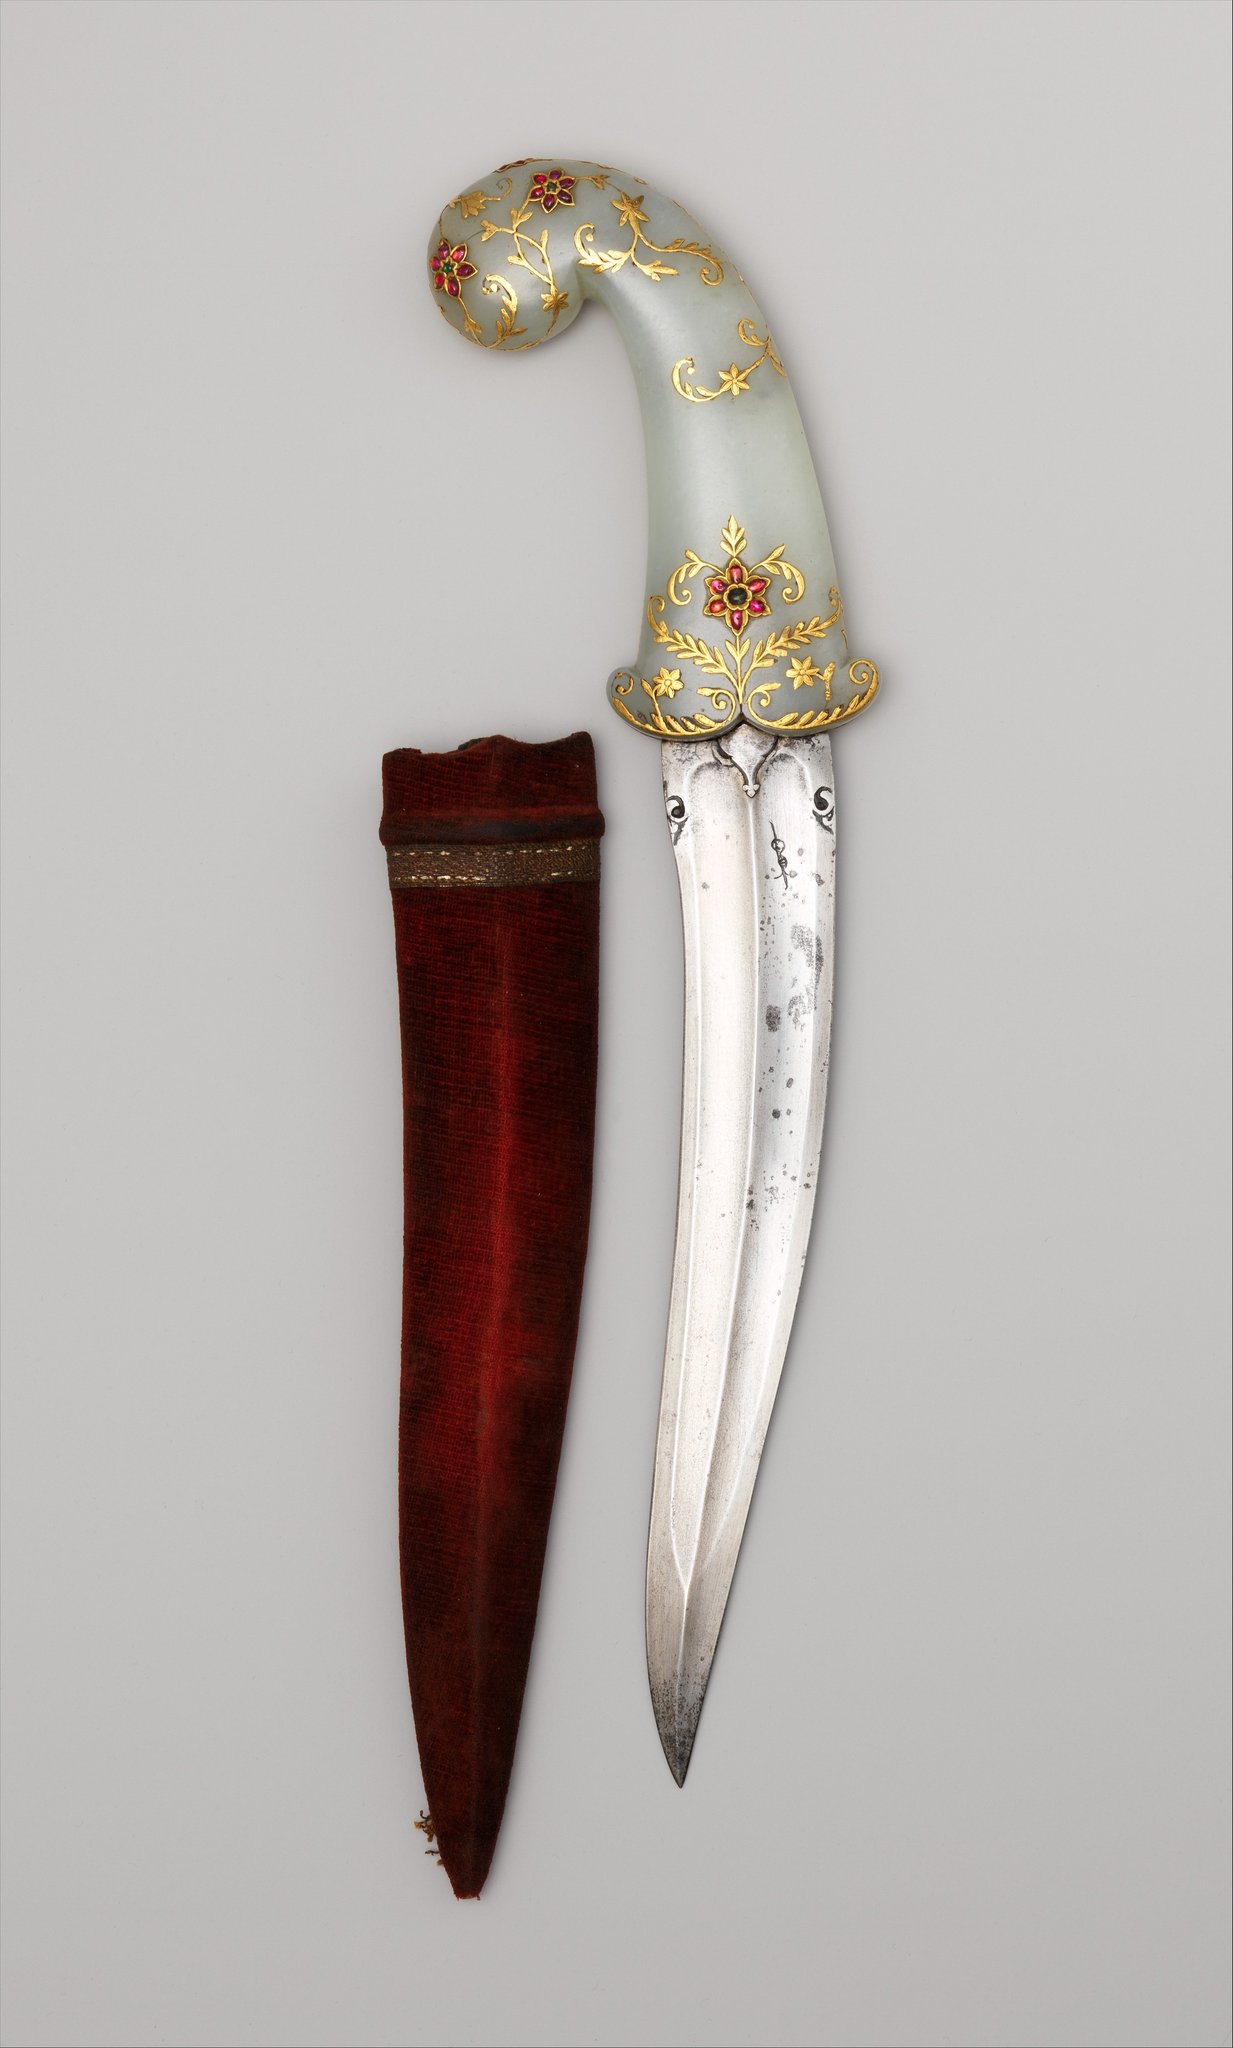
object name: dagger khanjar with sheath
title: Dagger (Khanjar) with Sheath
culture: indian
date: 1767-1800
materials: gemstone, gold, jade, steel, velvet, wood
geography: india